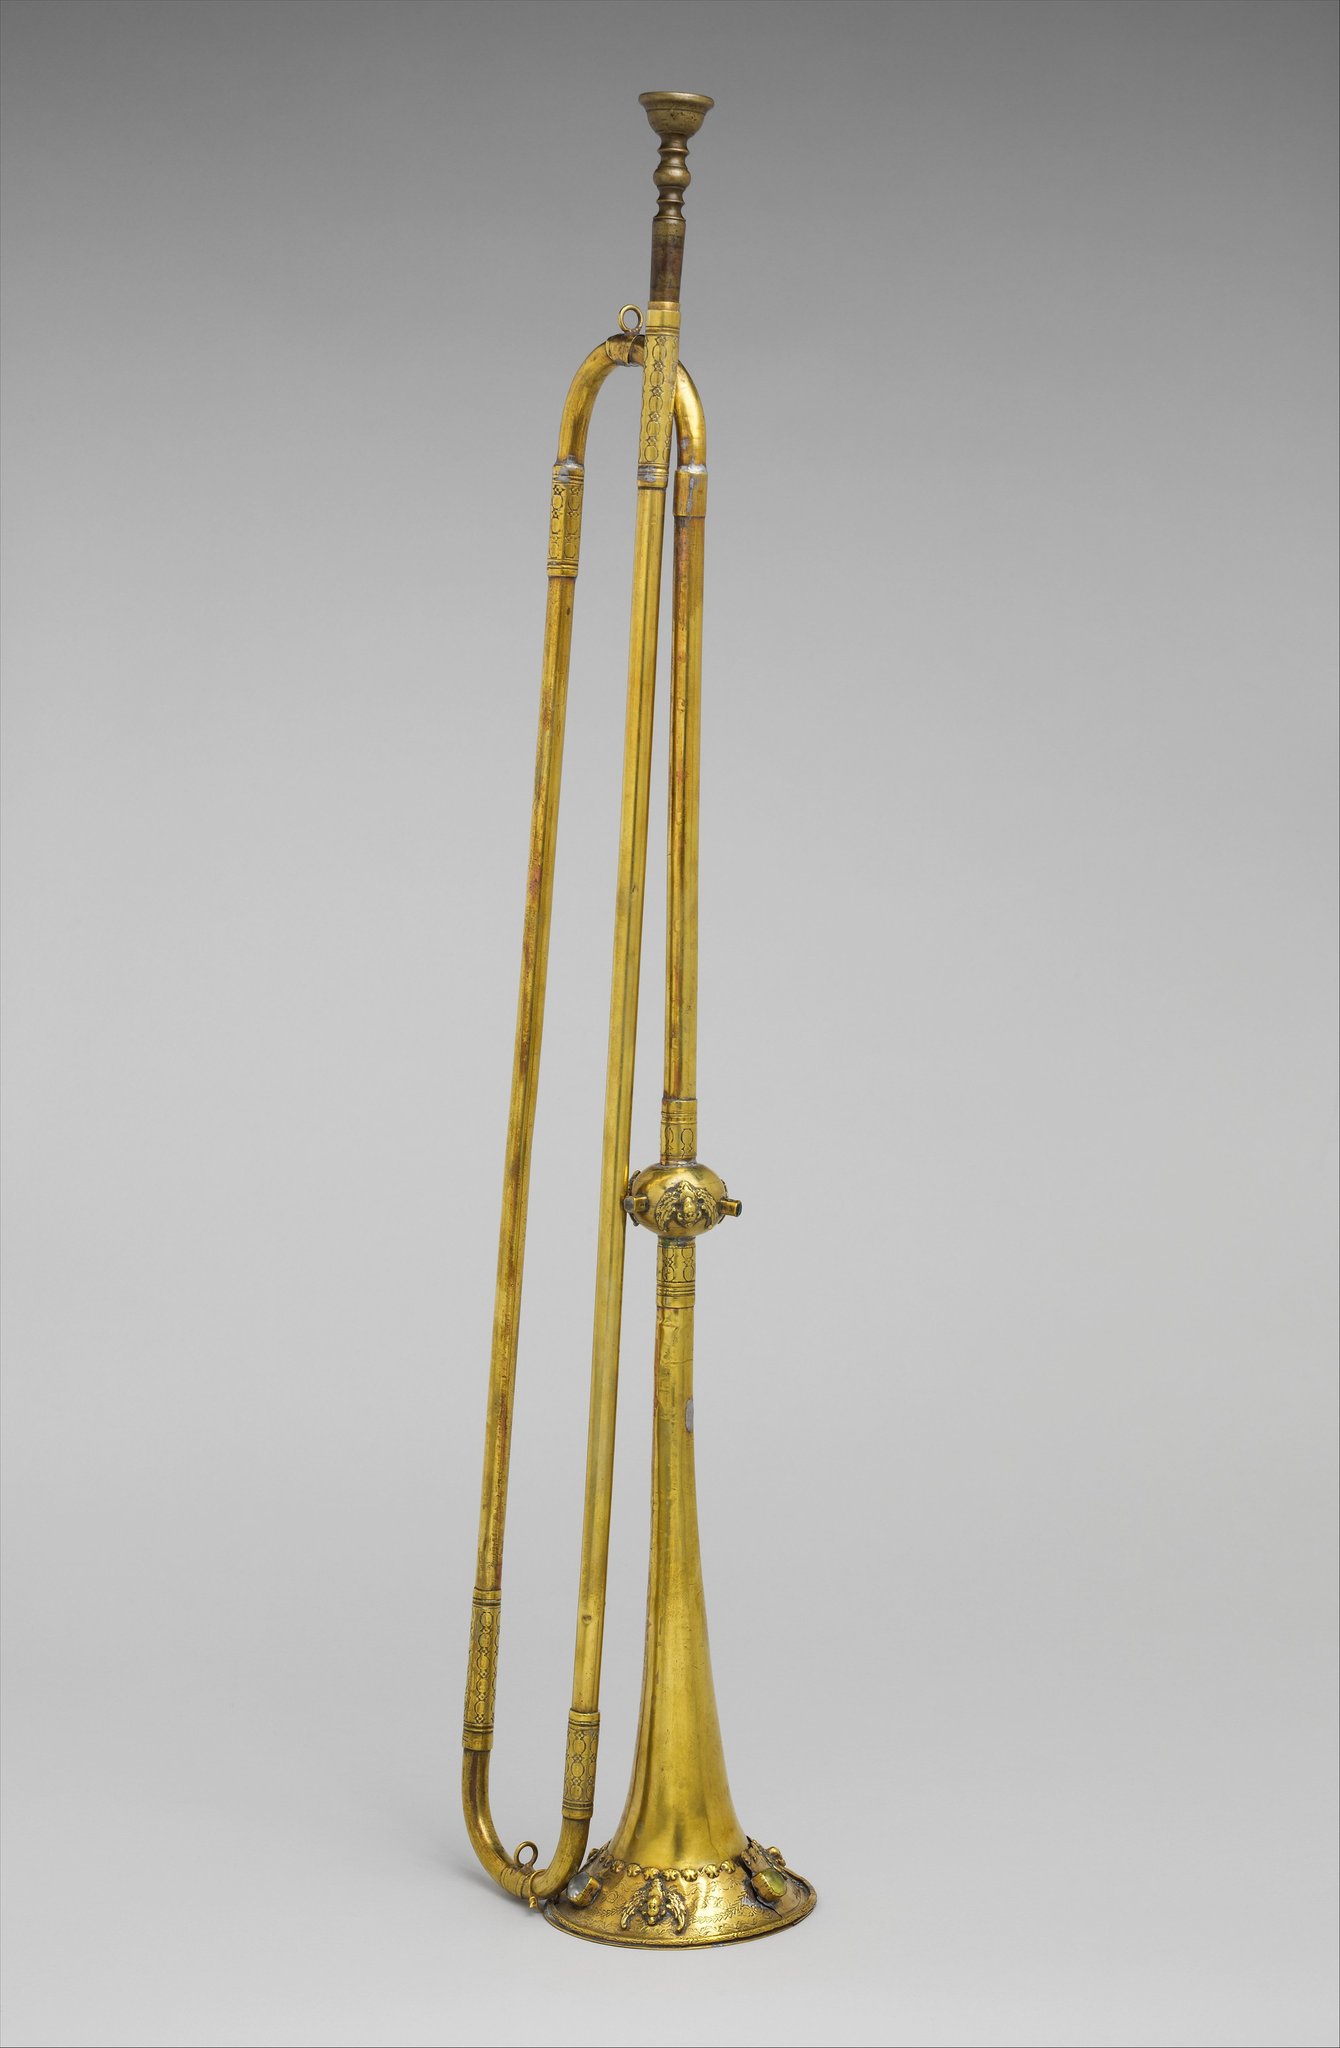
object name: trumpet in e flat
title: Natural Trumpet in D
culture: german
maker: andreas naeplaesnigg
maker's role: maker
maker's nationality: german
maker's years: 1780-1800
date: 1790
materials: brass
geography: germany